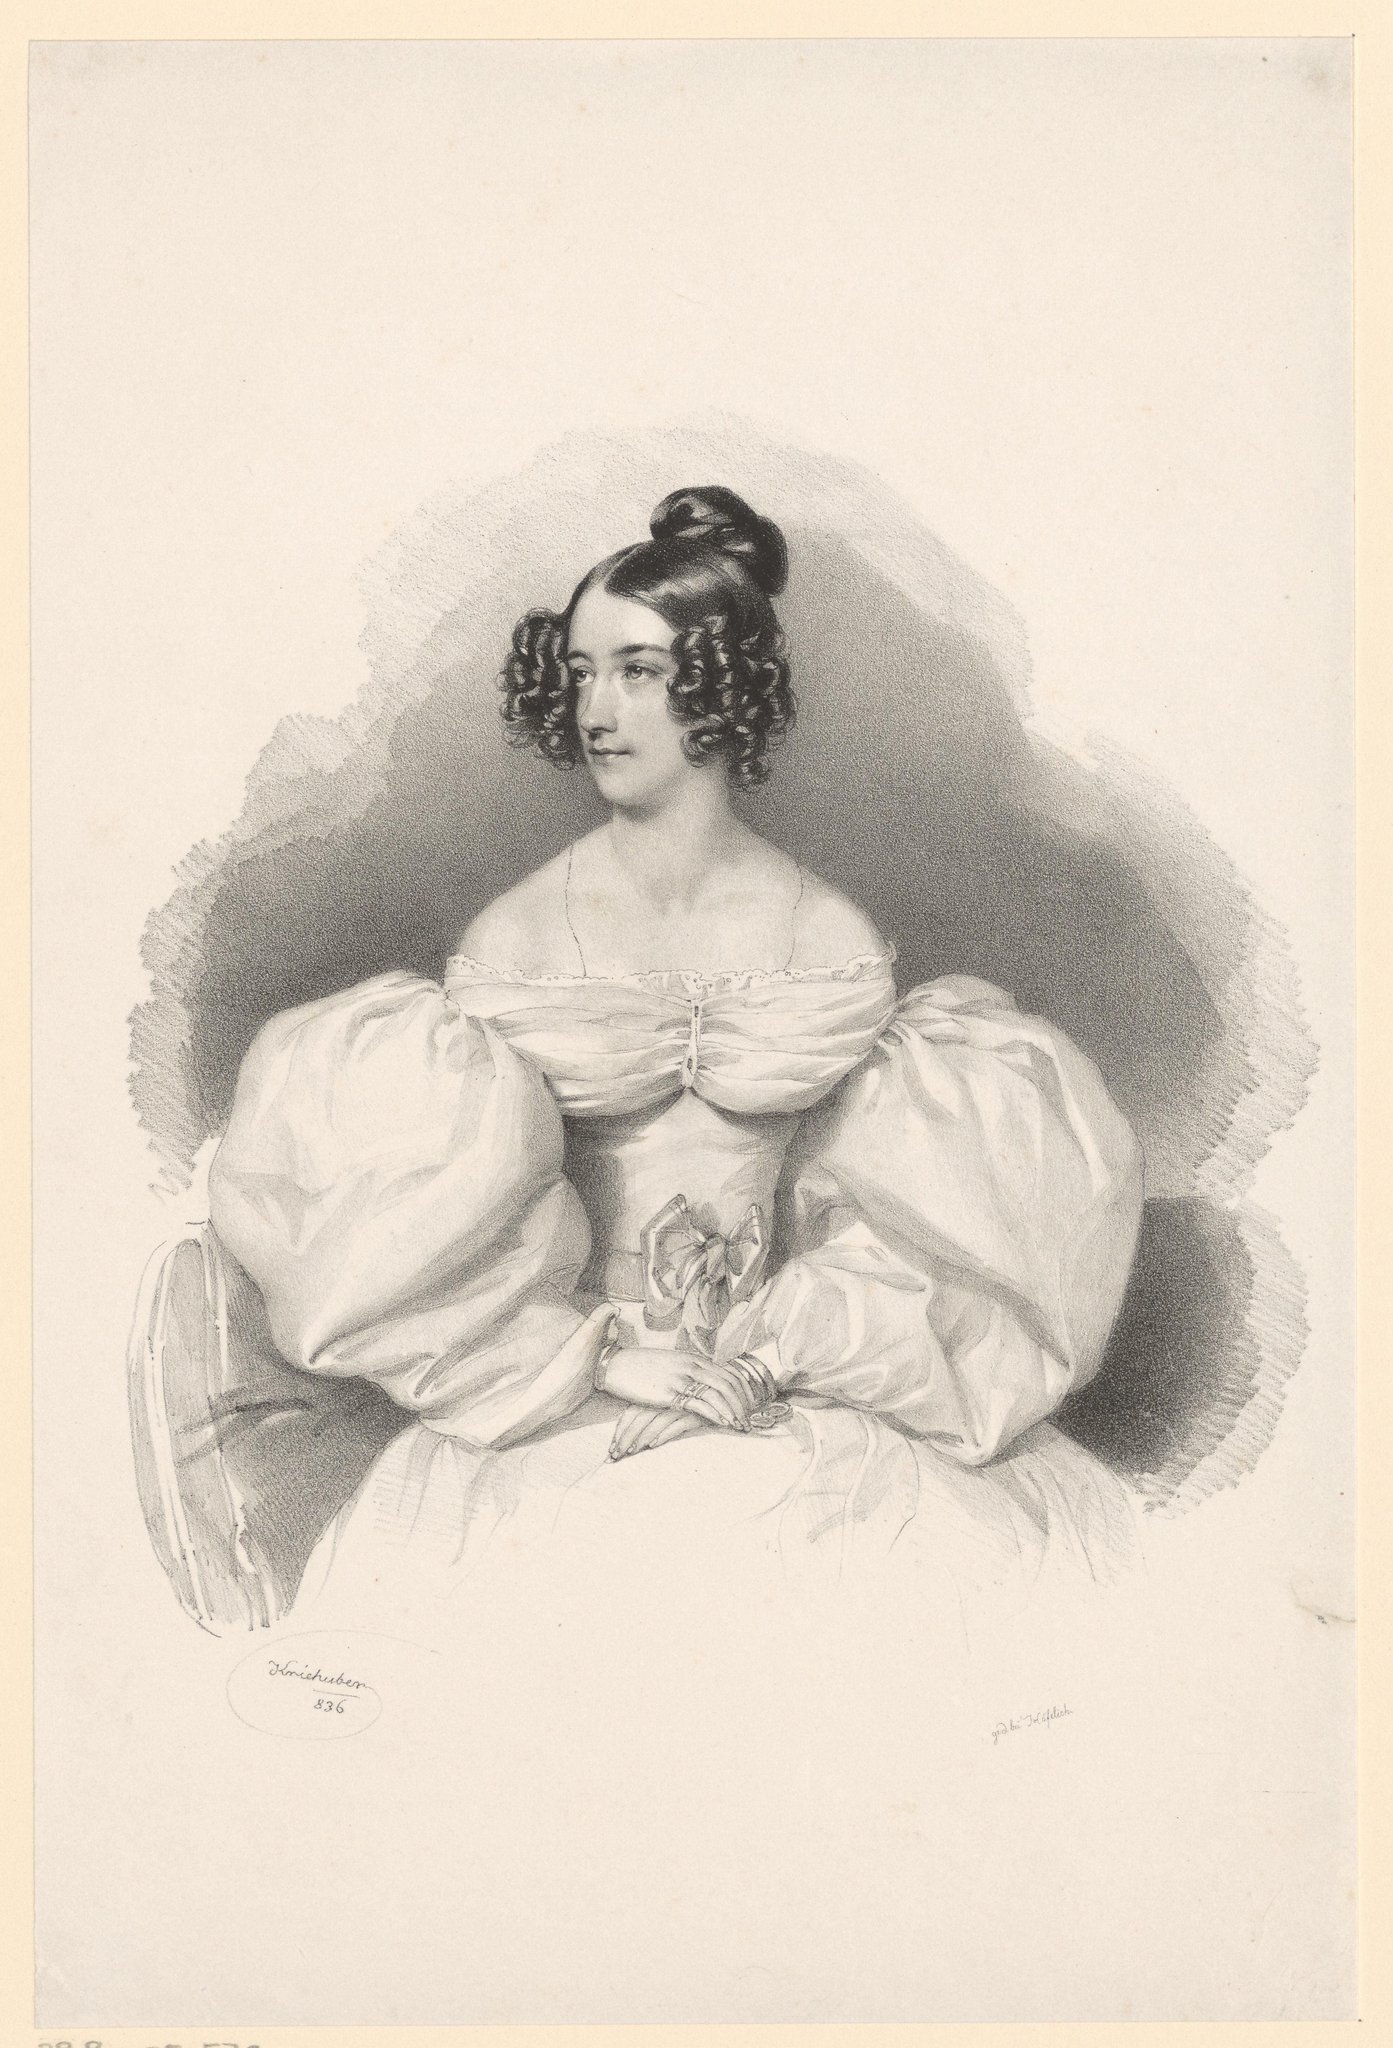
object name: print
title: Portret van een onbekende vrouw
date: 1836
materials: paper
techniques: lithograph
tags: sleeves, historical persons not known by name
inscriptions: collector's mark: Lugt 2228